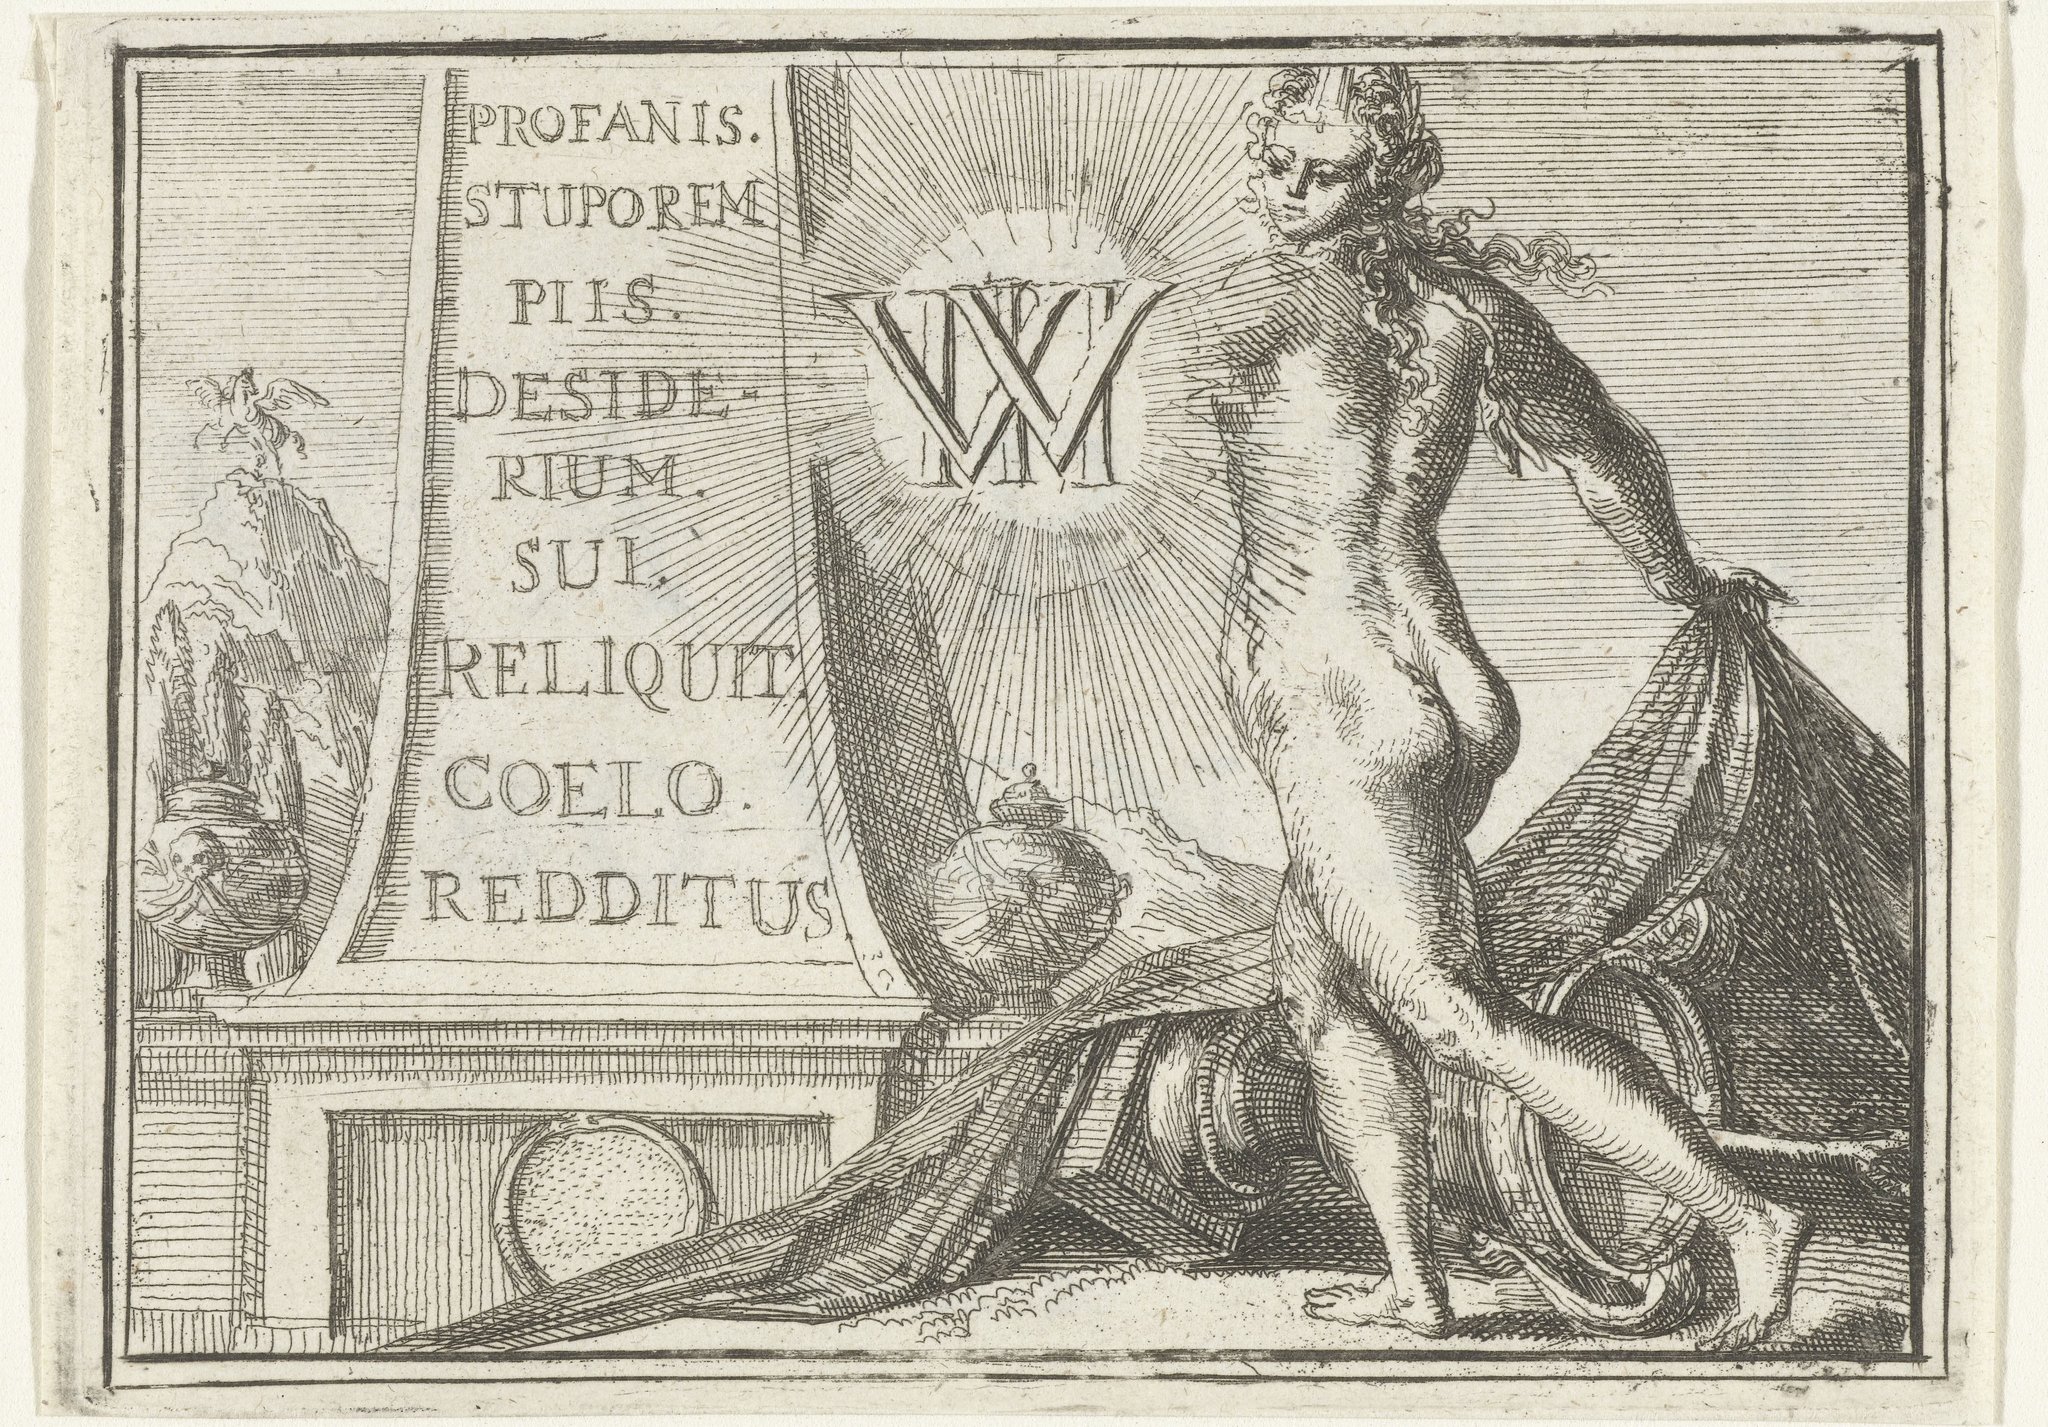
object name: print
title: Titelblad voor het pamflet: De Waarheid boven al, 1702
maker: romeyn de hooghe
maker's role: draughtsman, goldsmith, painter, print maker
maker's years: 1645-1708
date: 1702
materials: paper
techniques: engraving, etching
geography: netherlands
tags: the hague, william iii (prince of orange and king of england, scotland, and ireland), truth; 'verità' (ripa)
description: Naakte personificatie van de Waarheid bij een zuil en het stralende monogram van Willem III. Titel staat op apart tekstblad.